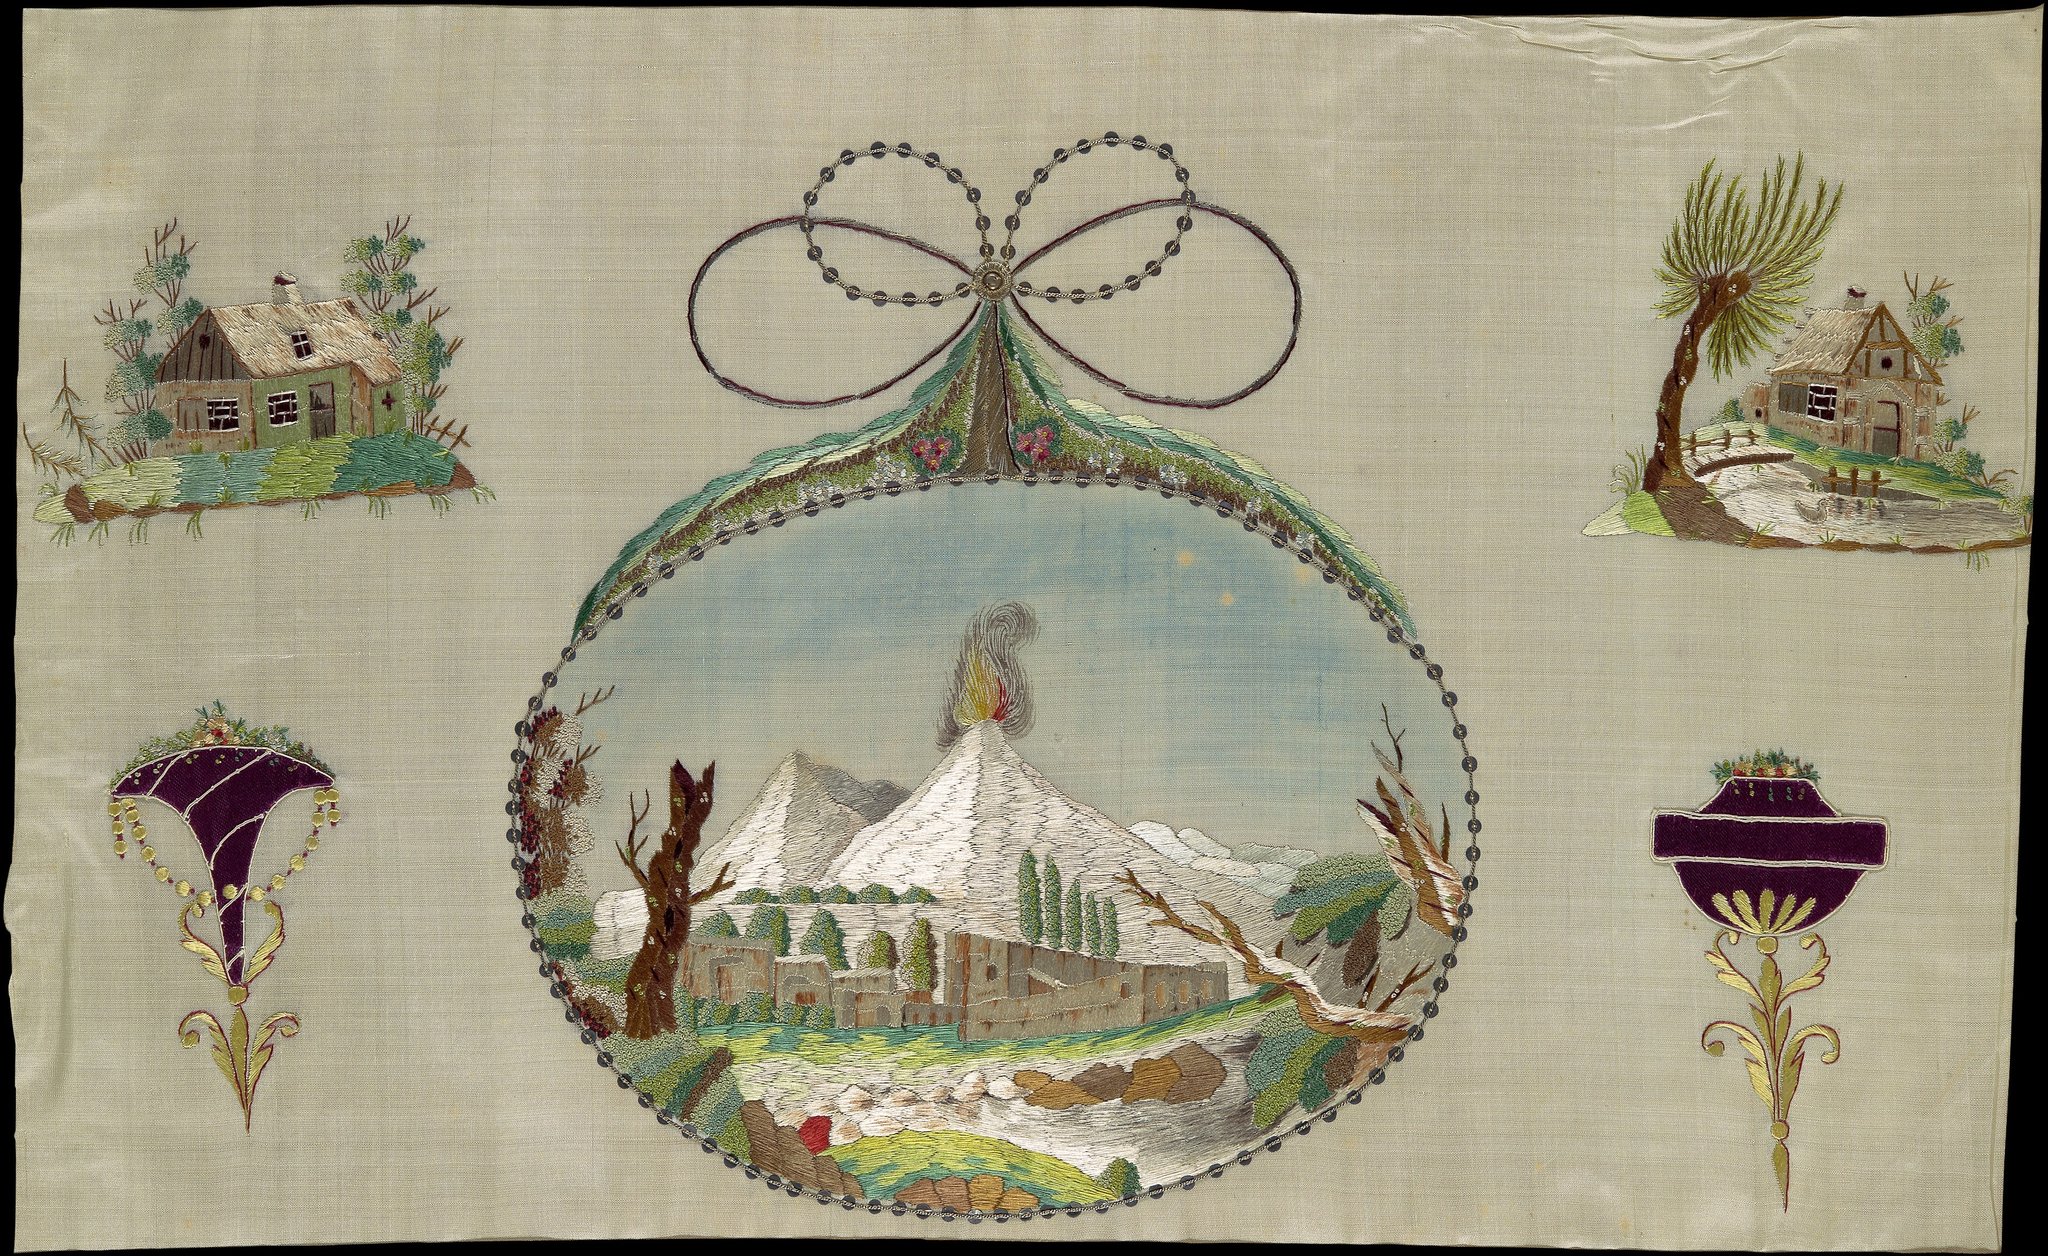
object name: book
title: Zeichen-Mahler und Stickerbuch zur Selbstbelehrung für Damen, Zweiter Theil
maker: johann friedrich netto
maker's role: designer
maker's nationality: german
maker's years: 1795-1809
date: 1798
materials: metal thread, silk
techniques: embroidery, engraving, hand coloring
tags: houses,mountains,trees,snow